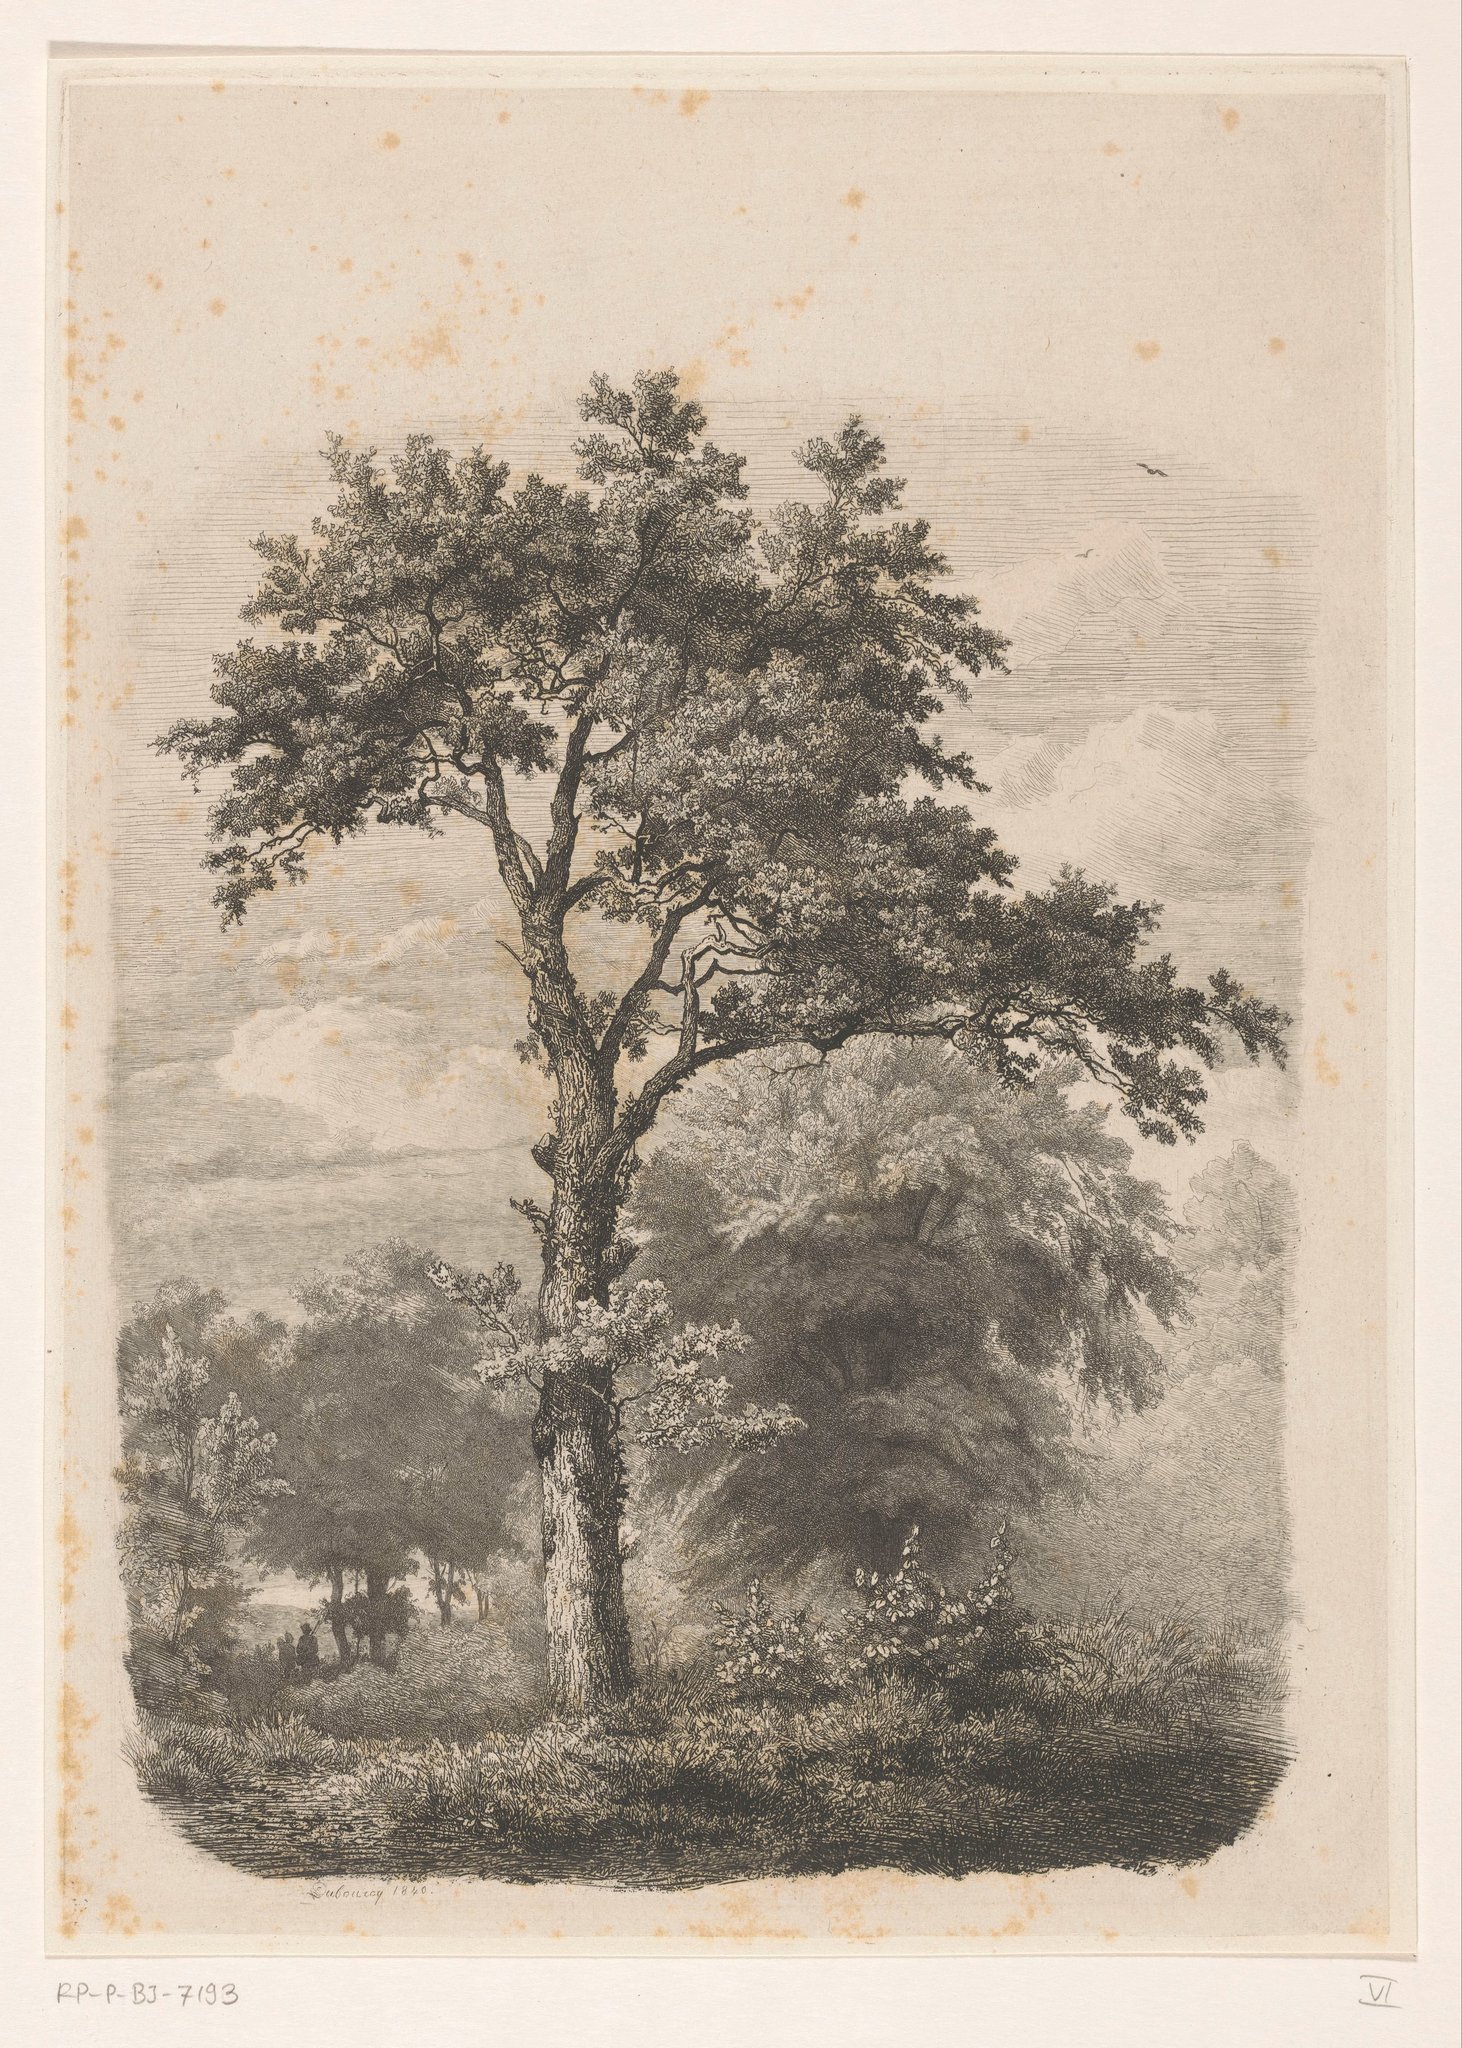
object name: print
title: Vijf etsproeven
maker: pierre louis dubourcq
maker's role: draughtsman, painter, print maker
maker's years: 1815-1873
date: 1840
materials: paper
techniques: drypoint, etching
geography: netherlands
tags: trees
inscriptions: collector's mark: Lugt 2228